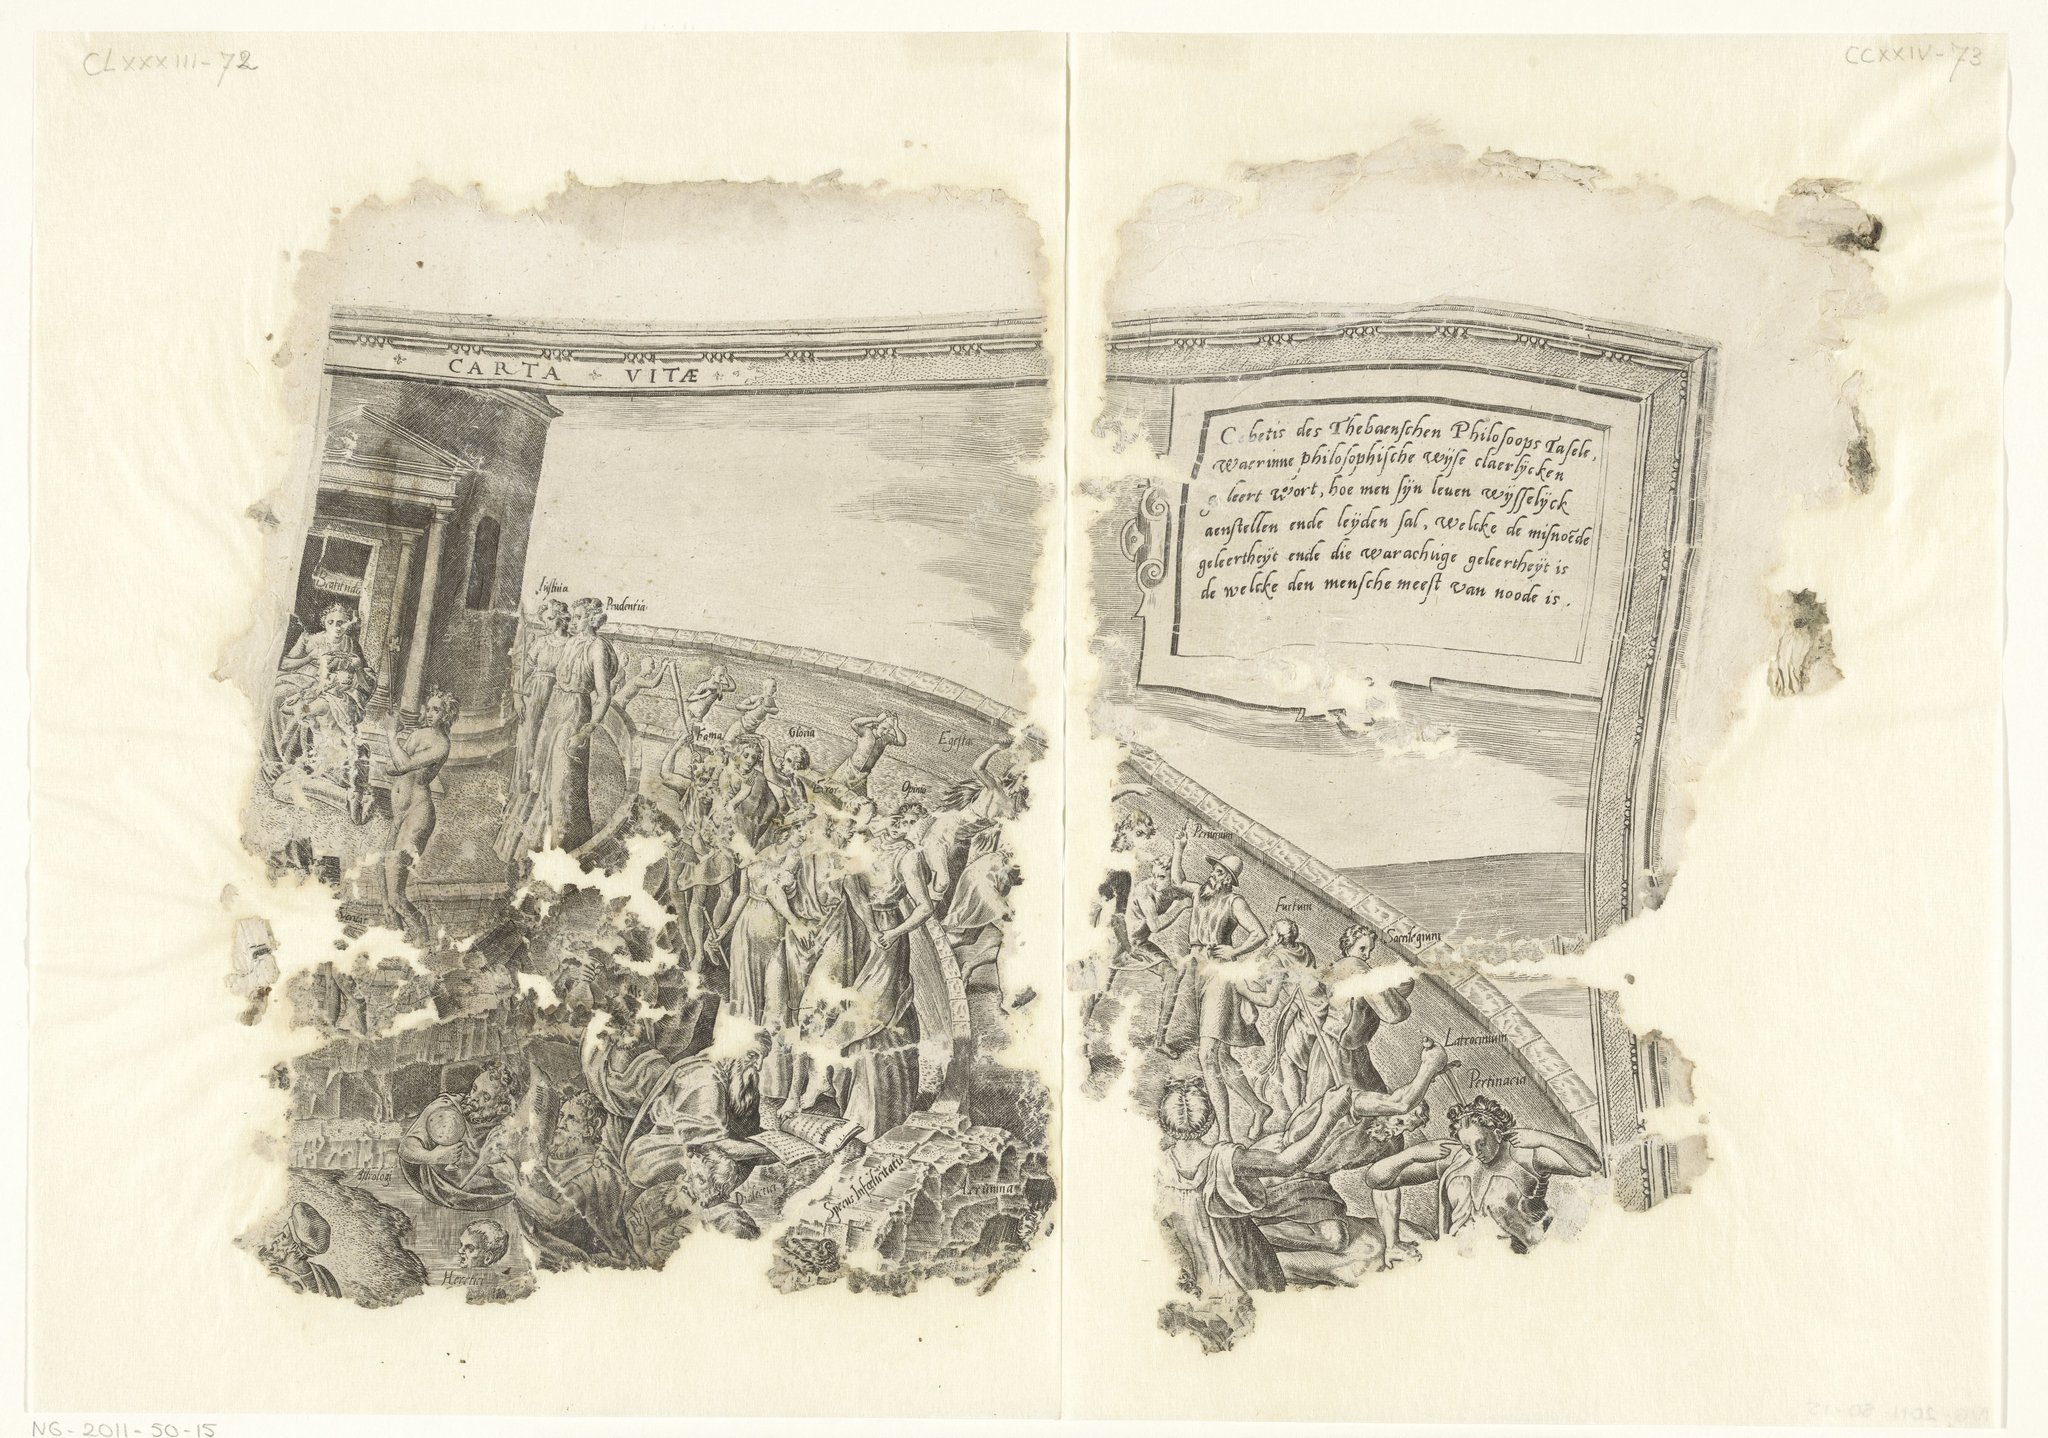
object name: print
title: Rechterbovenhoek van een prent van het tafereel van Cebes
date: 1561-1596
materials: paper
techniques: engraving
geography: southern netherlands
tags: 'tabula cebetis'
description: Allegorie over de heilsweg van de mens. Het leven als een stad met drie ommuurde terreinen, met in het midden een tempel. Bij de buitenste poort staan de zielen van kinderen te wachten, klaar om het volwassen leven te betreden. Voor het binnengaan krijgen zij iets te drinken van Verleiding (Seductio), die hen onwetend maakt. Het eerste ommuurde terrein toont allerlei ver- en afleidingen, zoals Vooroordeel (Opinio), Begeerte (Cupiduas), Twijfel (Error) en Onwetendheid (Ignorantia). Zij beletten de jeugdige mens verder door te dringen tot de volgende cirkel. Alleen door de personificaties te volgen van Berouw (Poenitentia), Hoop (Spes) en Goed Verlangen (Bonnem Desiderium) kan de mens toegang krijgen tot de tweede cirkel. Daar krijgt hij onderricht in alle vormen van wereldse kennis. Links staan de zeven artes liberales en rechts debatteren verschillende geleerden. De mens wordt in deze cirkel op de proef gesteld en geconfronteerd met valse kennis (Falsa Disciplina). Met behulp van Zelfbeheersing (Continentia) en Geduldigheid (Tolerantia) kan de berg verder worden beklommen. Het derde ommuurde terrein, ten slotte, wordt bewaakt door Waarheid (Veritas). Zij verleent de mens toegang tot het ware geluk. Hij wordt er verwelkomd door de kardinale deugden en mag verblijven in het huis van de gelukzaligen, waar het ware geluk op hem wacht. Gereconstrueerd uit twee fragmenten.